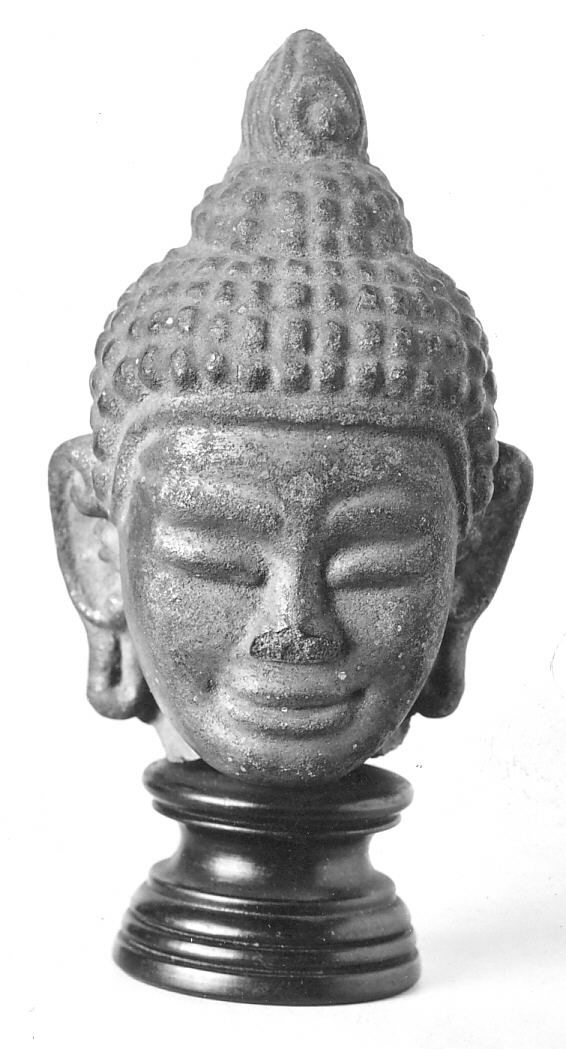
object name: head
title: Head of a Buddha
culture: cambodian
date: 801-900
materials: gilt, paint, stone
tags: heads,buddhism,buddha